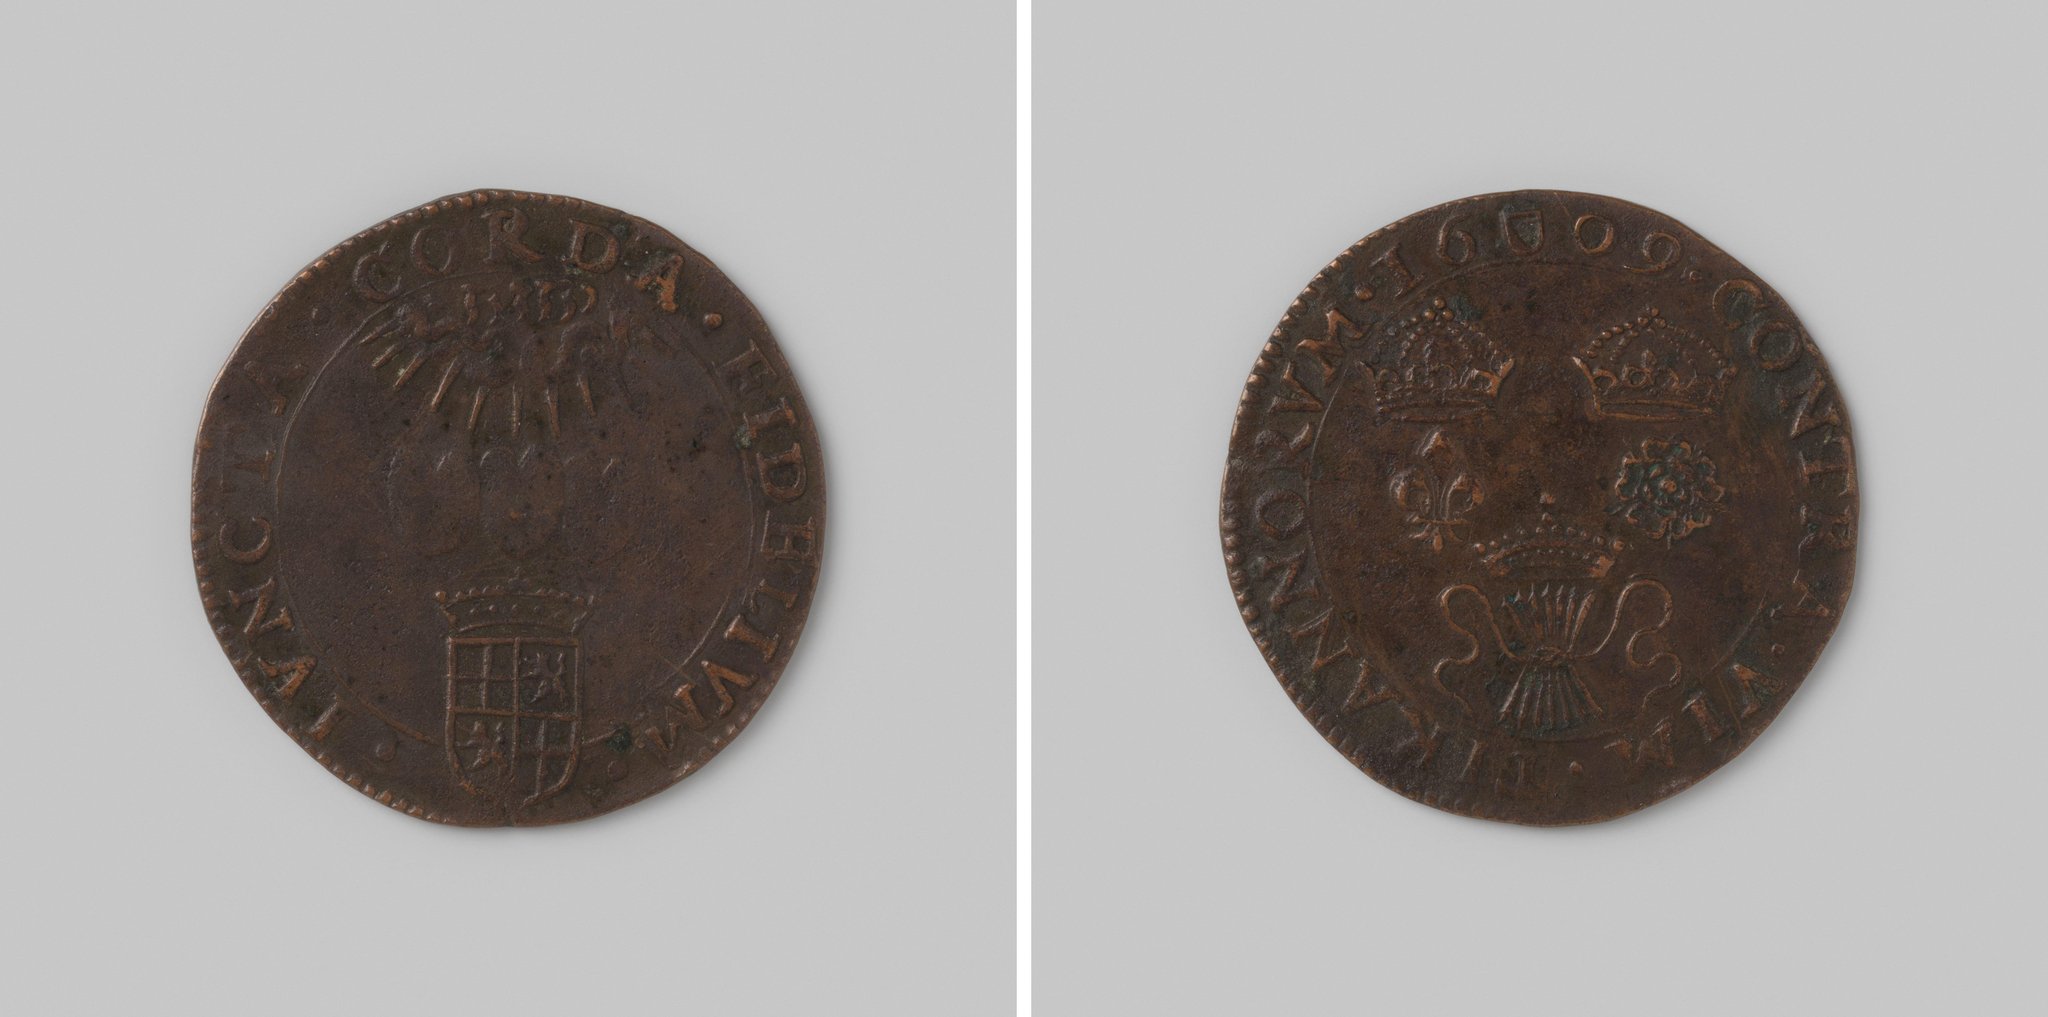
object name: history medal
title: Rekenpenning uit Utrecht op het vernieuwen van het verbond van Nederland met Engeland en Frankrijk 1609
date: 1609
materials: copper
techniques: striking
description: Koperen penning, op de voorzijde boven een wapenschild van de provincie Utrecht drie harten onder de stralende naam Gods, met omschrift, op de keerzijde de drie gekroonde emblemen lelie, roos en pijlenbundel, met omschrift.